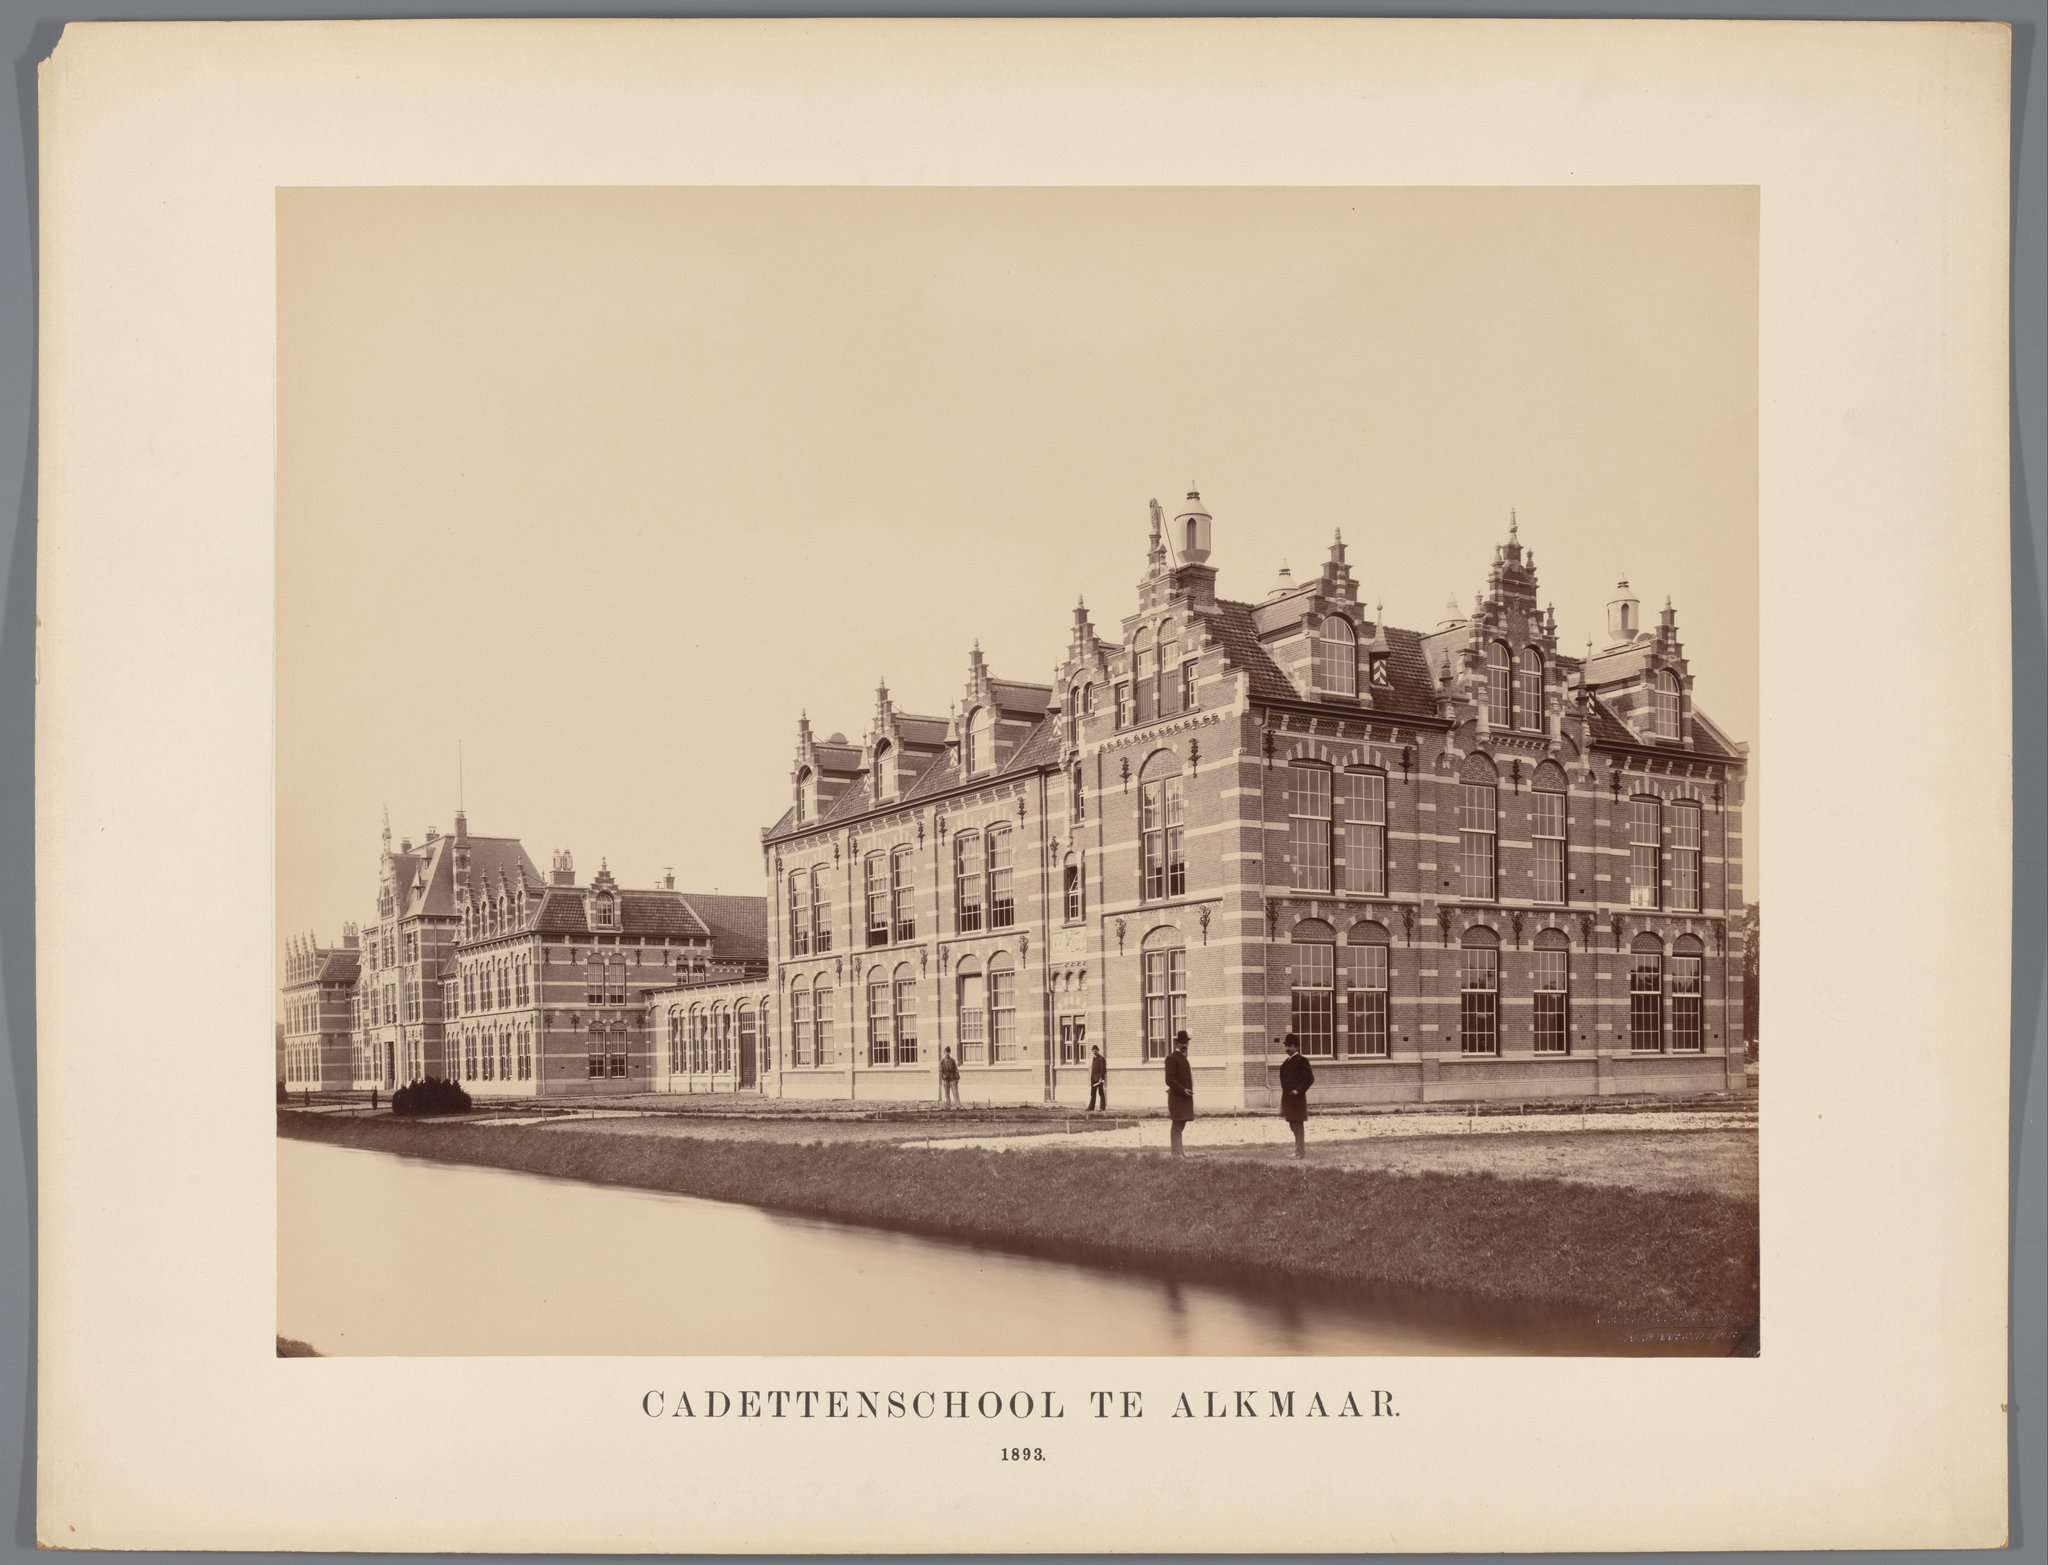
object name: photograph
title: Cadettenschool te Alkmaar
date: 1893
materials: cardboard, paper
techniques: photography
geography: alkmaar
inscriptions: date